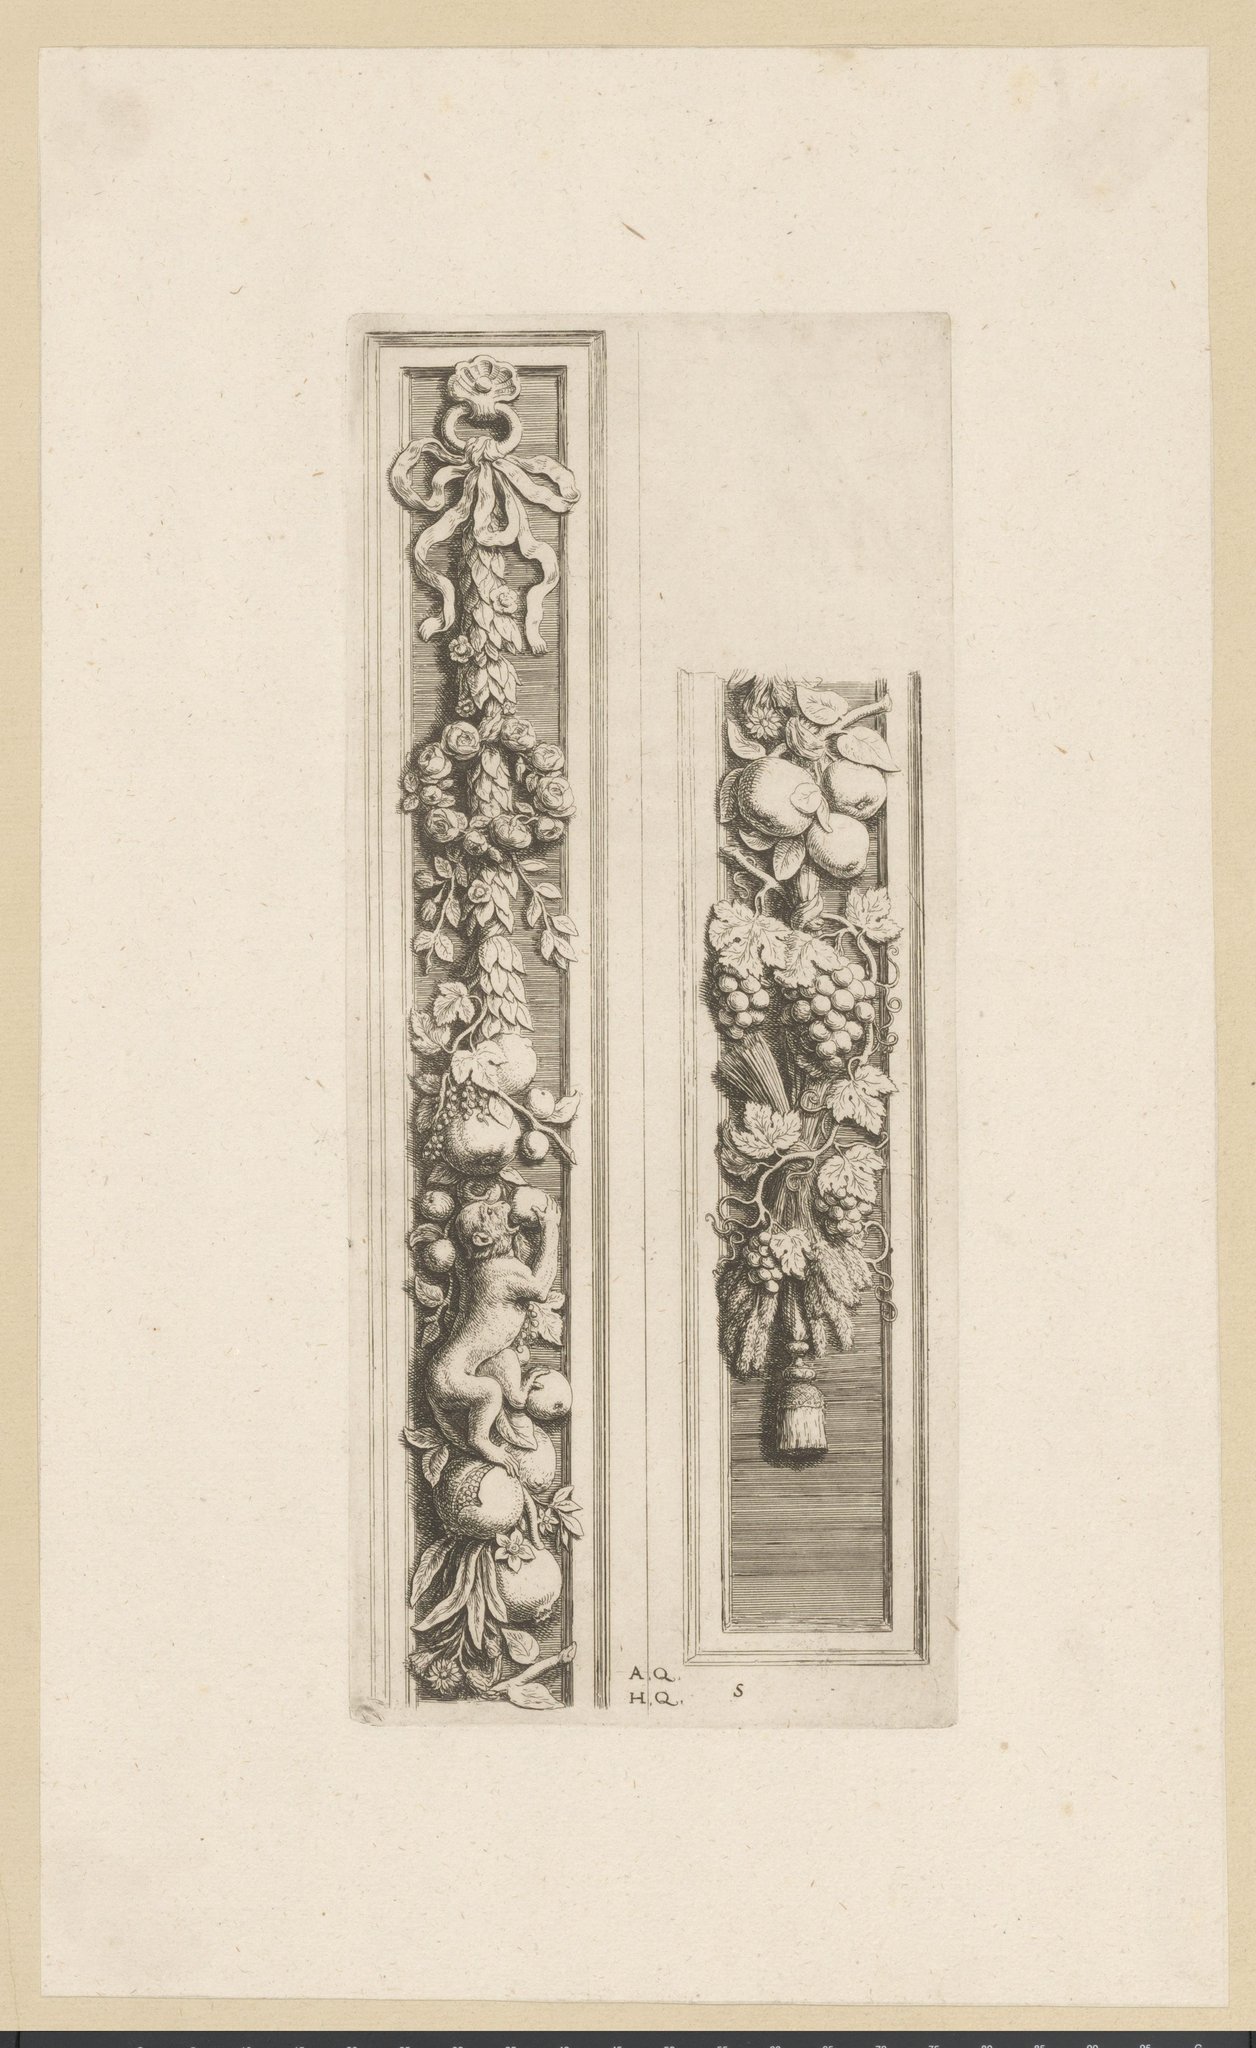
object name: print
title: Pilasterfestoen met aap, fruit, bloemen en bladeren tussen galerij en Burgerzaal in het Stadhuis op de Dam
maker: hubert quellinus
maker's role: print maker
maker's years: 1619-1687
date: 1655-1665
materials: paper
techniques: engraving, etching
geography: amsterdam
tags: fruits and vegetables ~ ornament, monkeys, apes, townhall, ornament ~ festoon, garland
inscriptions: collector's mark: ‘16,59’ Lugt 1641b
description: Prent gebruikt in: Prima pars. Praecipuarum effigierum ac ornamentorum, amplissimae Curiae Amstelrodamensis (…) / Het eerste deel. Van de voornaemste Statuen ende Ciraten, vant konstijck Stadhuys van Amstelredam, tmeeste in marmer gemaeckt, door Artus Quellinus, Beelthouwer der voorseyde Stadt / La Premier Partie. De plusieurs Figures et ornements, de la Maison de Ville d'Amsterdam (…). Amsterdam: Artus Quellinus (I), 1655. Zie RP-P-AO-22-1-1 voor bijhorende titelpagina. Zie RP-P-AO-22-1-2 voor bijhorend register. Zie RP-P-AO-22-1A, RP-P-AO-22-1B, RP-P-AO-22-1C, RP-P-AO-22-1D-1, RP-P-AO-22-1D-2, RP-P-AO-22-1E, RP-P-AO-22-1F, RP-P-AO-22-1G, RP-P-AO-22-1H, RP-P-AO-22-1I, RP-P-AO-22-1K-1, RP-P-AO-22-1K-2, RP-P-AO-22-1K-3, RP-P-AO-22-1K-4, RP-P-AO-22-1K-5, RP-P-AO-22-1L-1, RP-P-AO-22-1L-2, RP-P-AO-22-1M-1, RP-P-AO-22-1M-2, RP-P-AO-22-1N-1, RP-P-AO-22-1N-2, RP-P-AO-22-1N-3, RP-P-AO-22-1N-4, RP-P-AO-22-1N-5, RP-P-AO-22-1O-1, RP-P-AO-22-1O-2, RP-P-AO-22-1O-3, RP-P-AO-22-1O-4, RP-P-AO-22-1P-1, RP-P-AO-22-1P-2, RP-P-AO-22-1P-3, RP-P-AO-22-1P-4, RP-P-AO-22-1Q-1, RP-P-AO-22-1Q-2, RP-P-AO-22-1Q-3, RP-P-AO-22-1Q-4, RP-P-AO-22-1R-1, RP-P-AO-22-1R-2, RP-P-AO-22-1R-3, RP-P-AO-22-1R-4, RP-P-AO-22-1R-5, RP-P-AO-22-1S-1, RP-P-AO-22-1S-3, RP-P-AO-22-1S-4, RP-P-AO-22-1S-5, RP-P-AO-22-1T-1 en RP-P-AO-22-1T-2 voor andere prenten uit deze publicatie. Zelfde staat van prent ook gebruikt in: Prima pars. Praecipuarum effigierum ac ornamentorum, amplissimae Curiae Amstelrodamensis (…) / Het eerste deel. Van de voornaemste Statuen ende Ciraten, vant konstijck Stadhuys van Amstelredam, tmeeste in marmer gemaeckt, door Artus Quellinus, Beelthouwer der voorseyde Stadt / La Premier Partie. De plusieurs Figures et ornements, de la Maison de Ville d'Amsterdam (…). Amsterdam: Frederik de Wit, 1665. Latere staat van prent ook gebruikt in: Architecture peinture et sculpture de la Maison de Ville d'Amsterdam, representee en CIX. figures en taille-douce (…). Amsterdam: David Mortier, 1719. En in: Architecture peinture et sculpture de la Maison de Ville d'Amsterdam, representee en CIX. figures en taille-douce (…). Amsterdam: Gerard Valck, 1719. En in: Bouw schilder en beeldhouwkonst, van het Stadhuis te Amsteldam, vertoont in CIX figuuren (…). Amsterdam: Covens & Mortier & Covens Jr., s.a. (1774-1783).